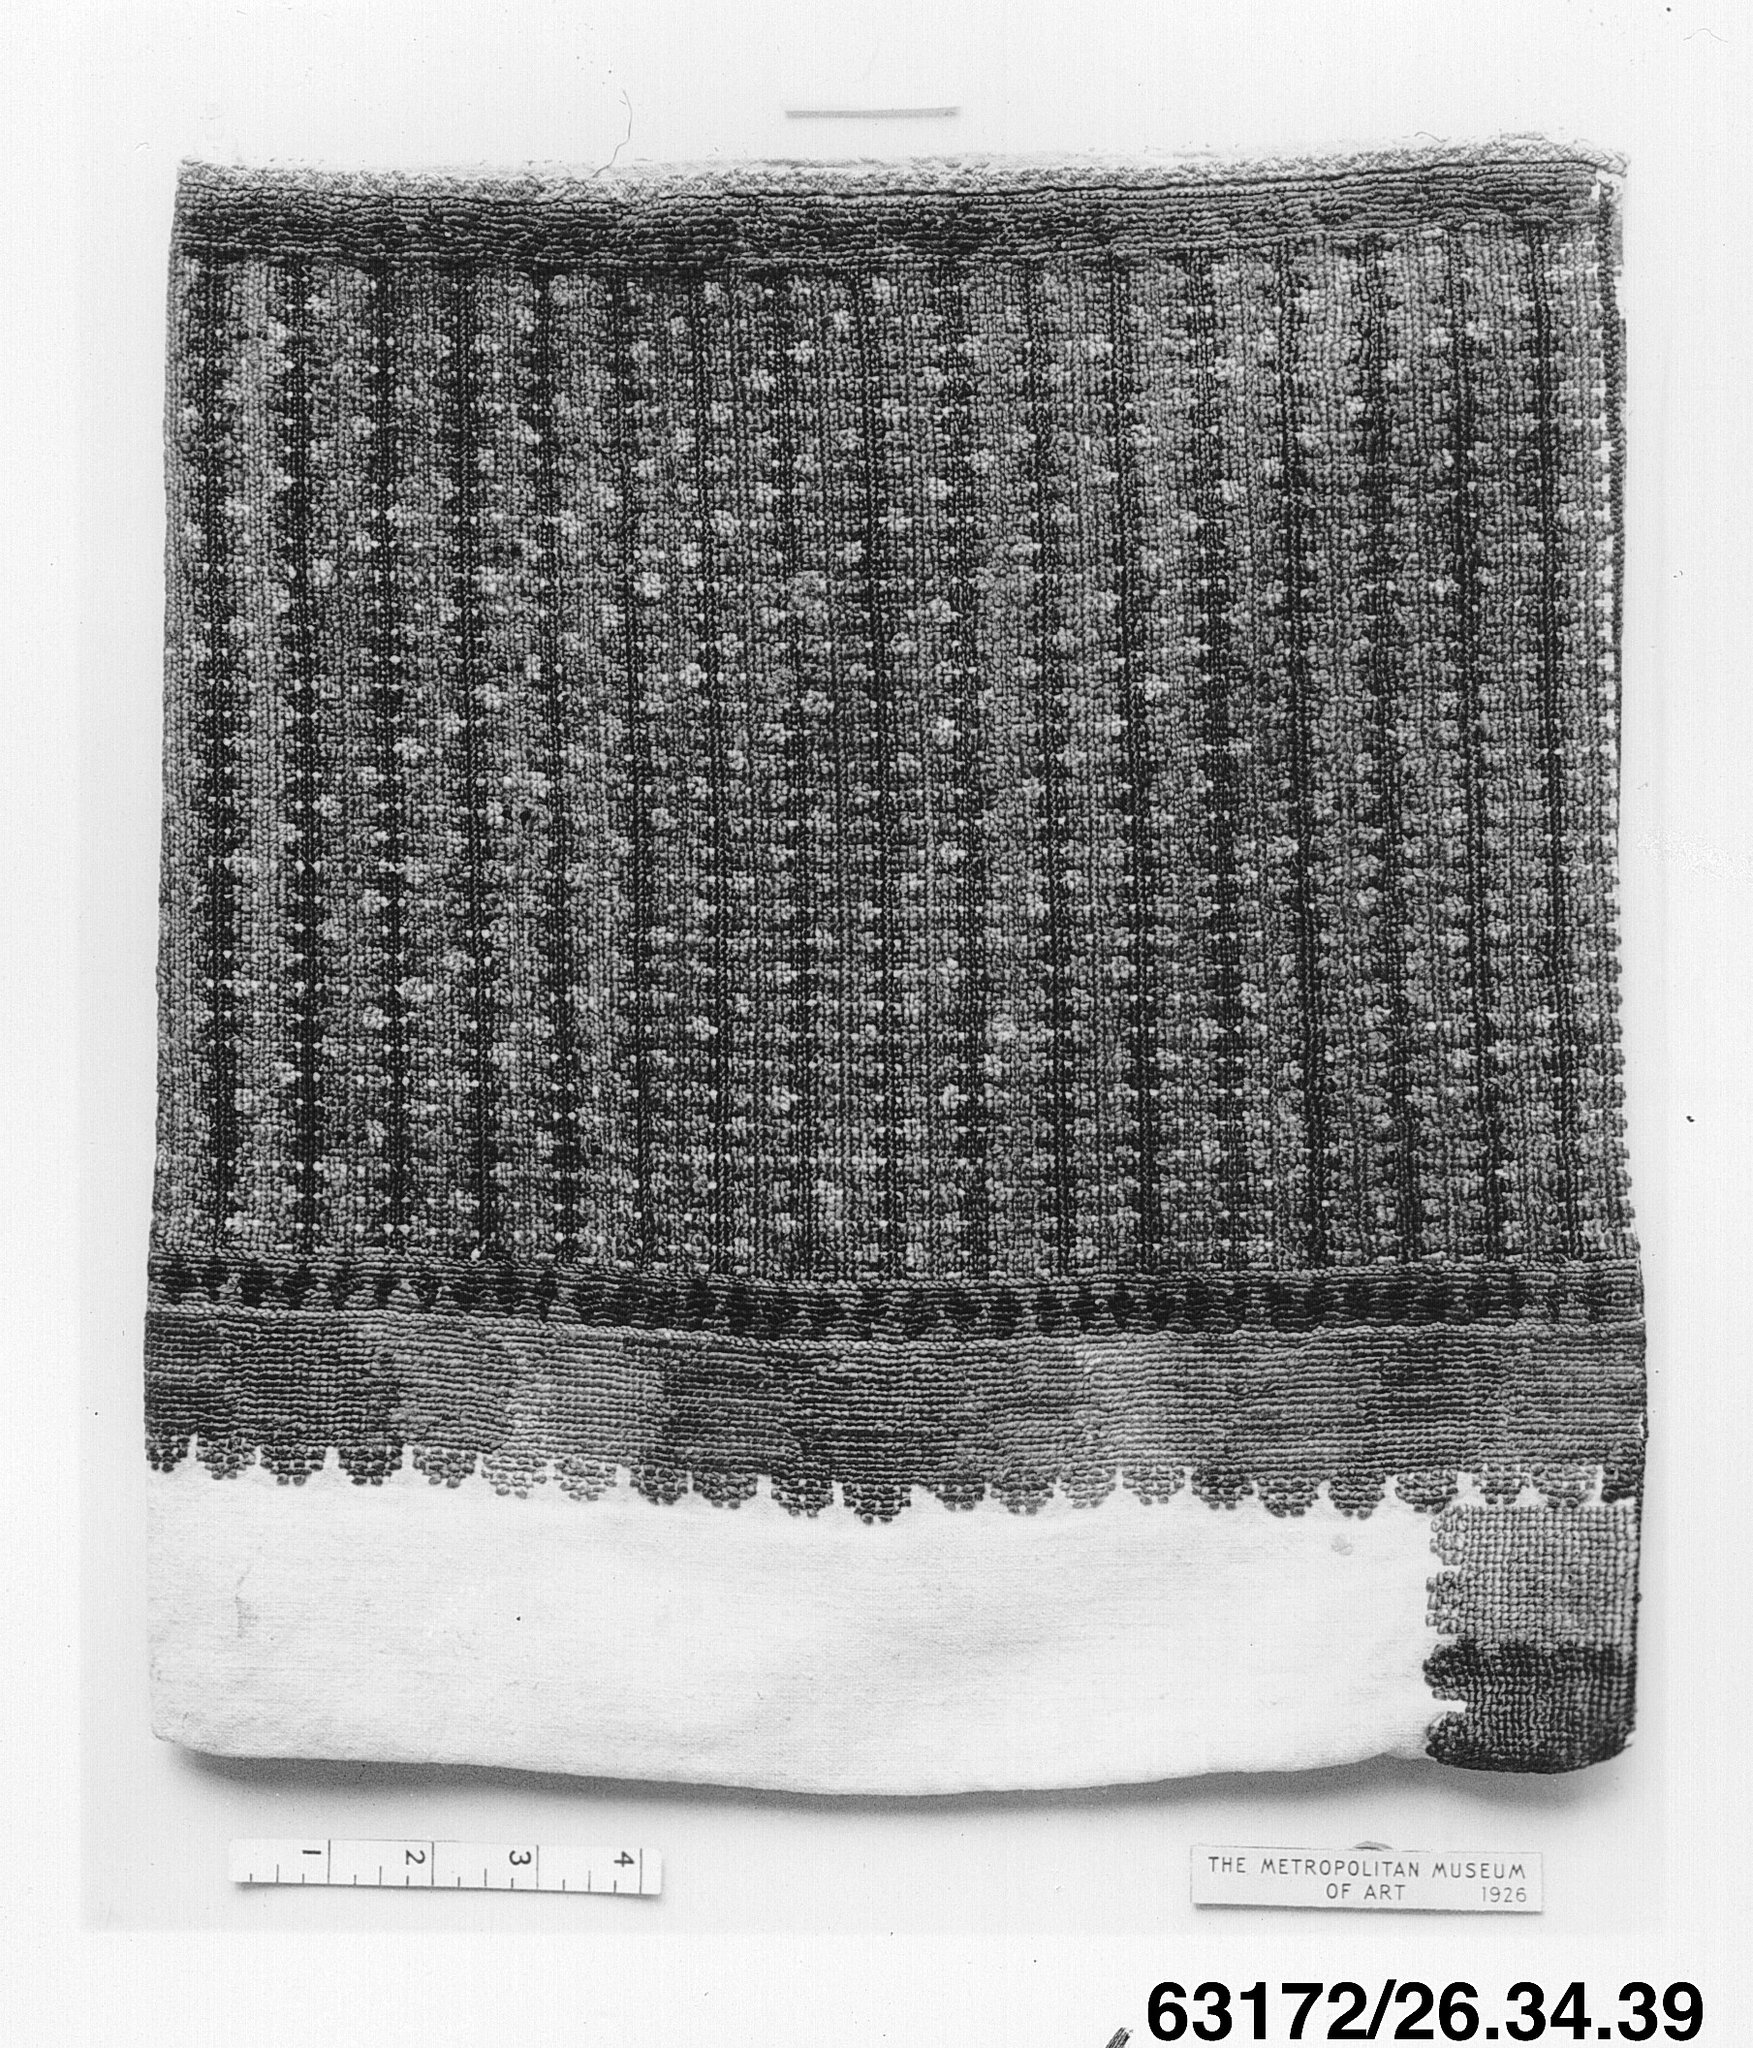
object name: sleeve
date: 1701-1800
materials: linen, silk